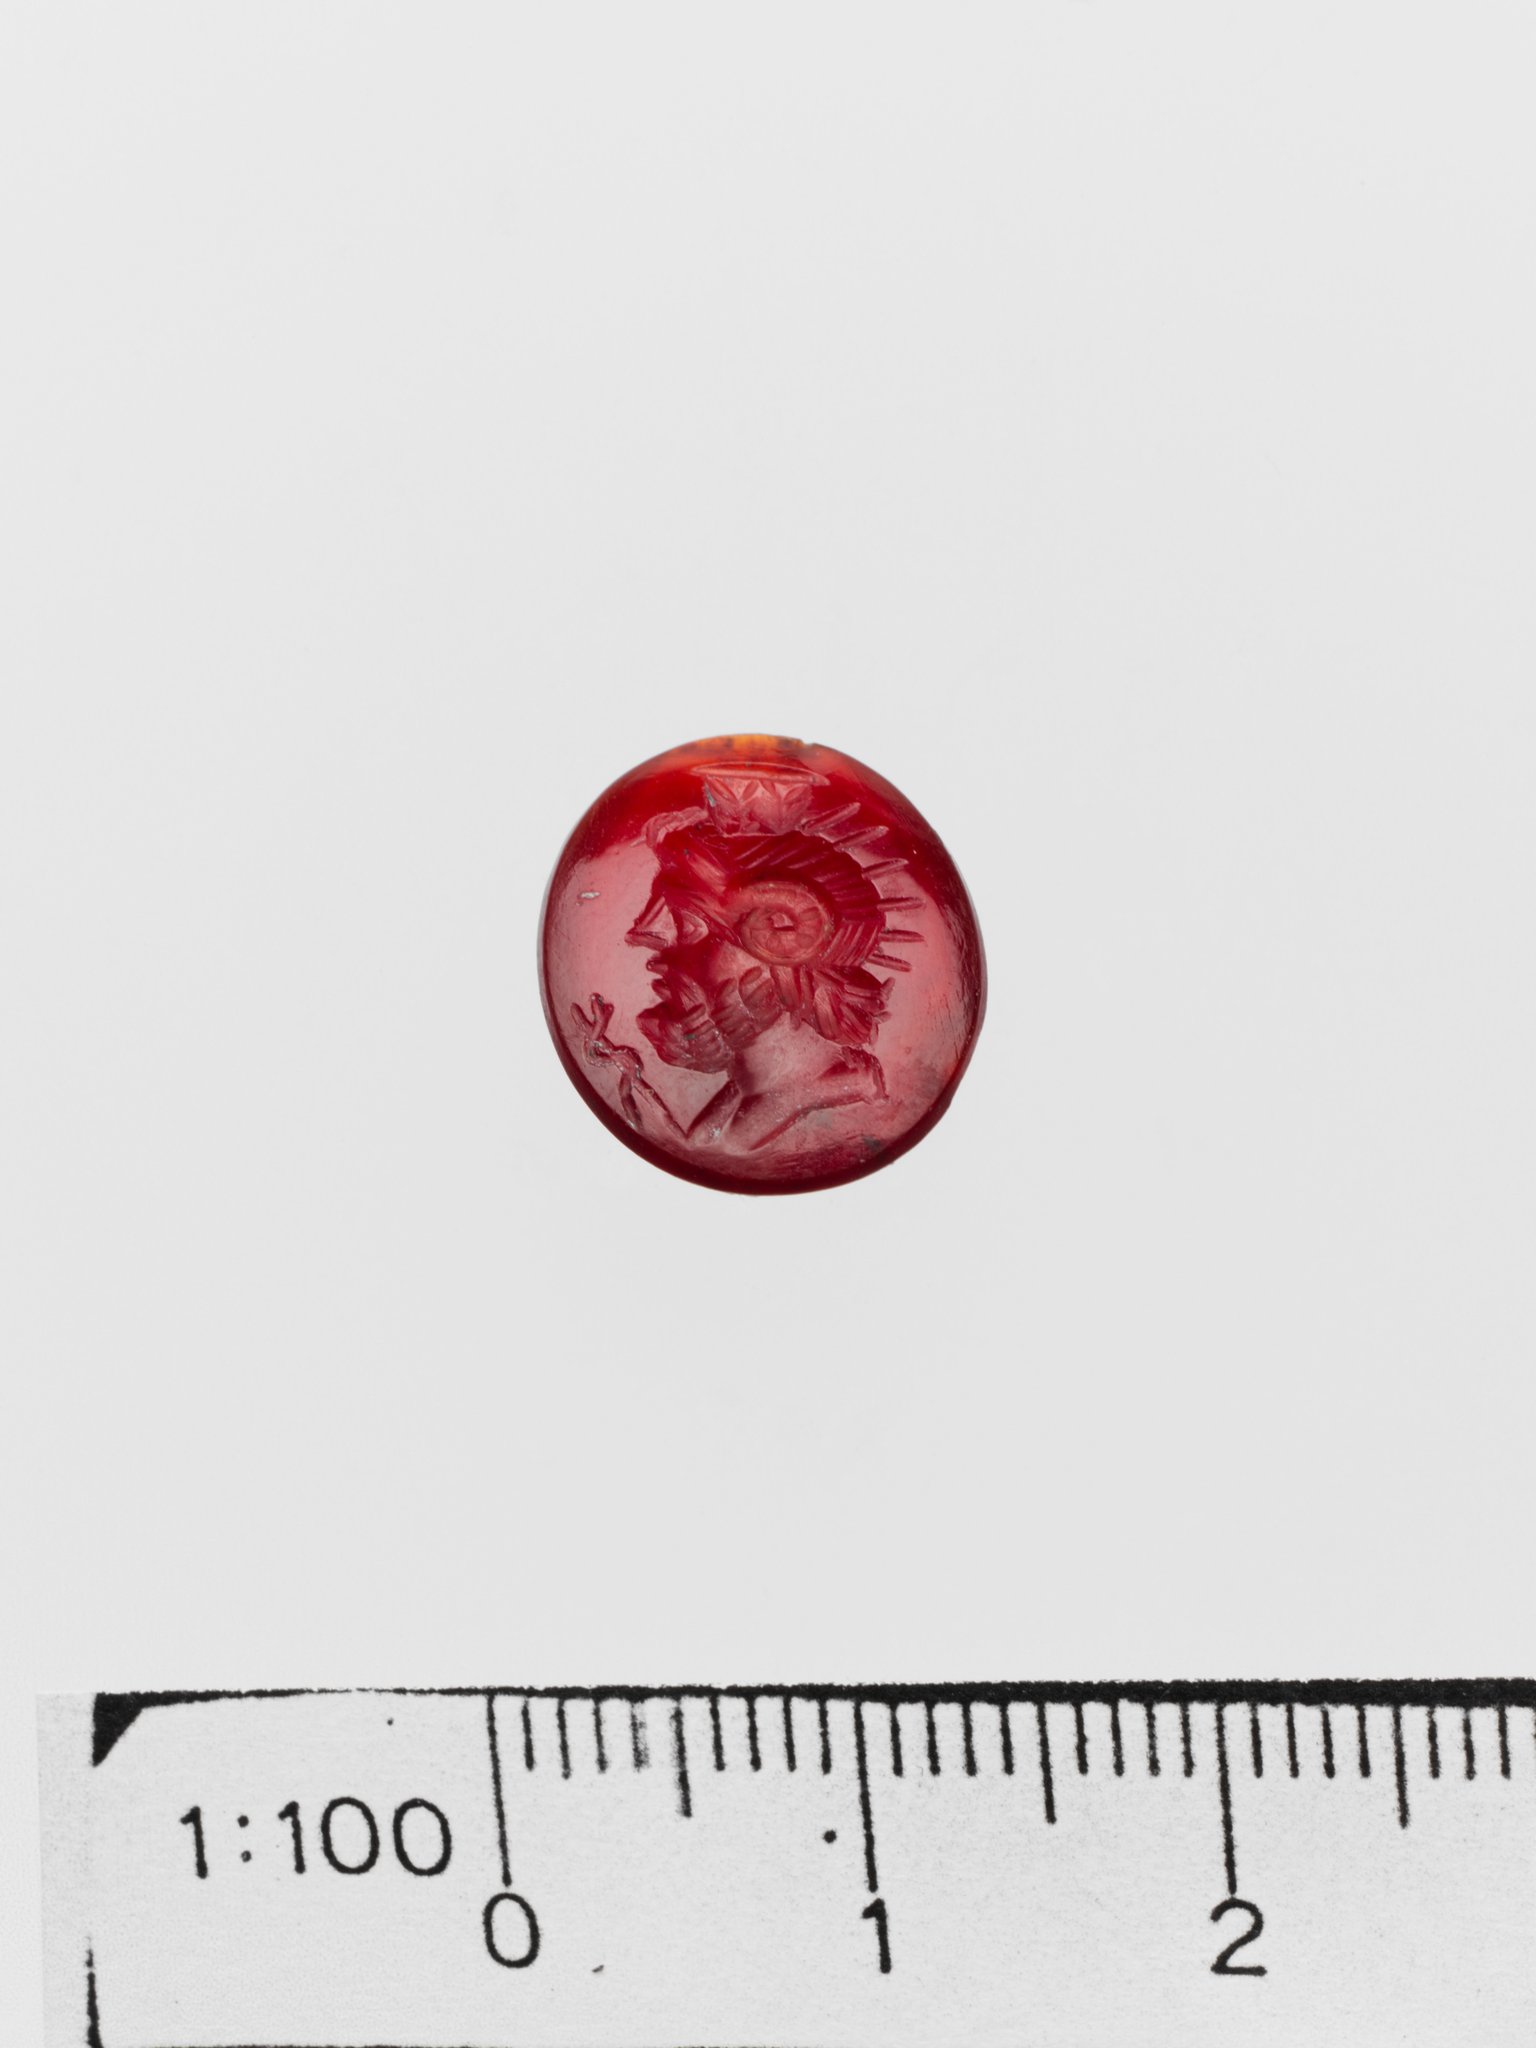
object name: intaglio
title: Carnelian ring stone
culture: roman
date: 100 BCE-300 CE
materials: gemstone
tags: helmets,men,profiles